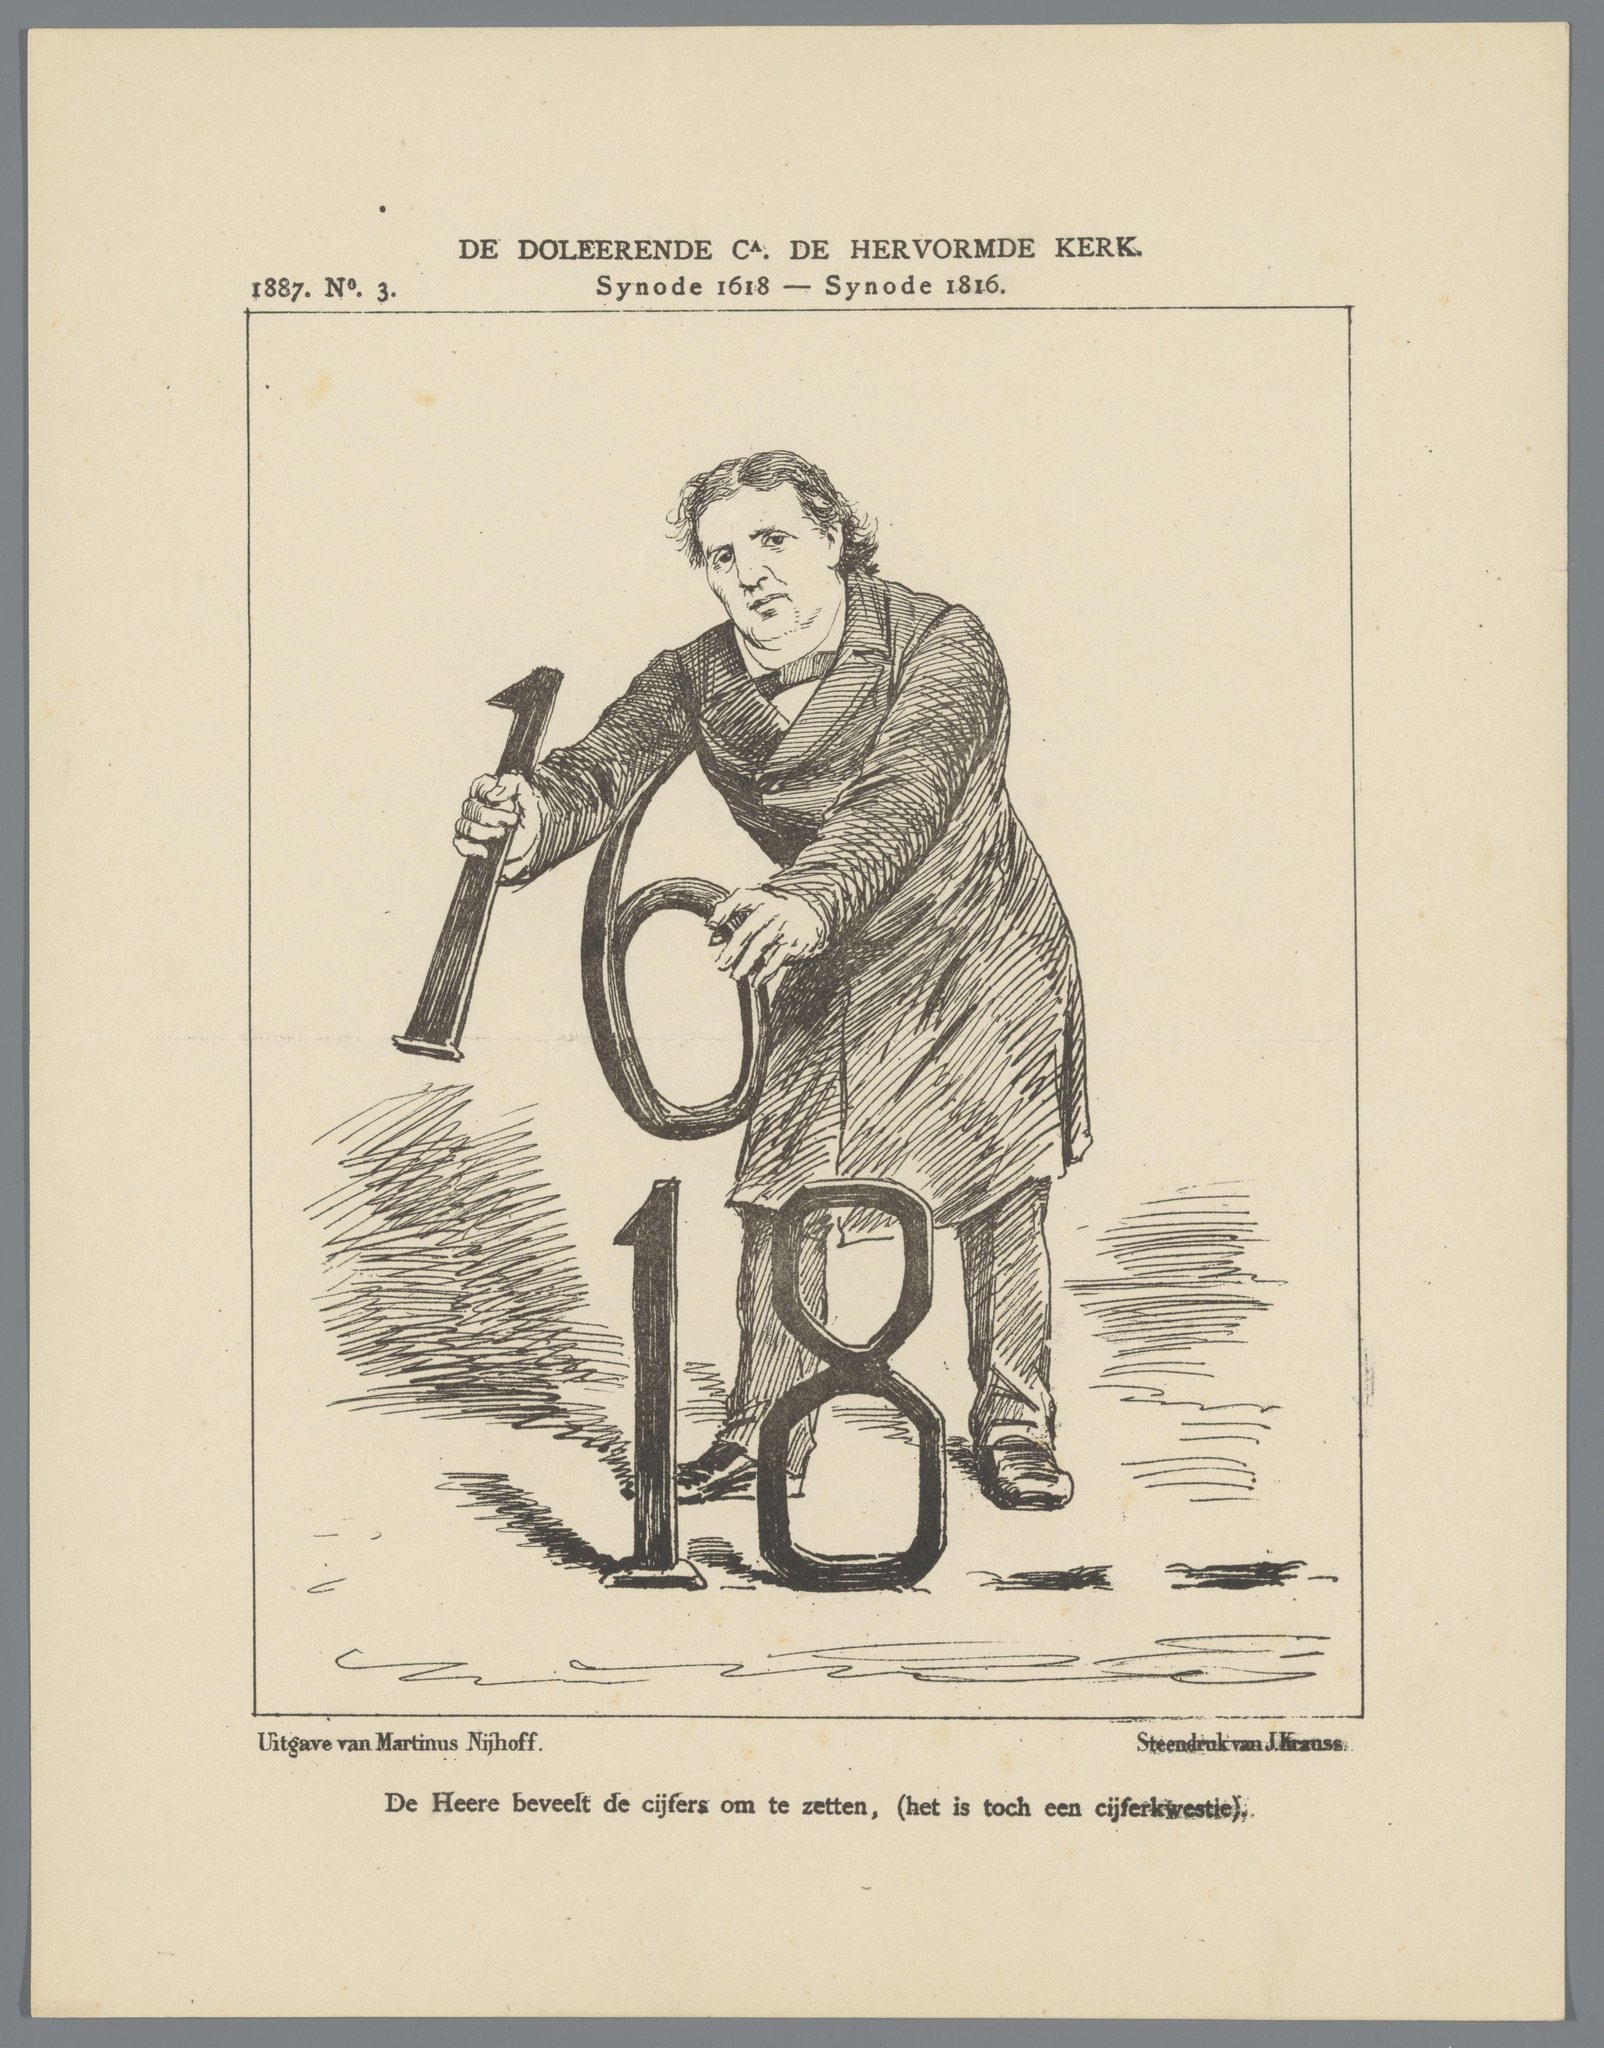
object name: cartoon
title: Spotprent met Abraham Kuyper, 1887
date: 1887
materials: paper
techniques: lithograph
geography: netherlands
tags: the hague, abraham kuyper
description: Spotprent met Abraham Kuyper en de synode van de Hervormde Kerk. Plaat verschenen bij het weekblad De Nederlandsche Spectator, nr. 3, 1887.